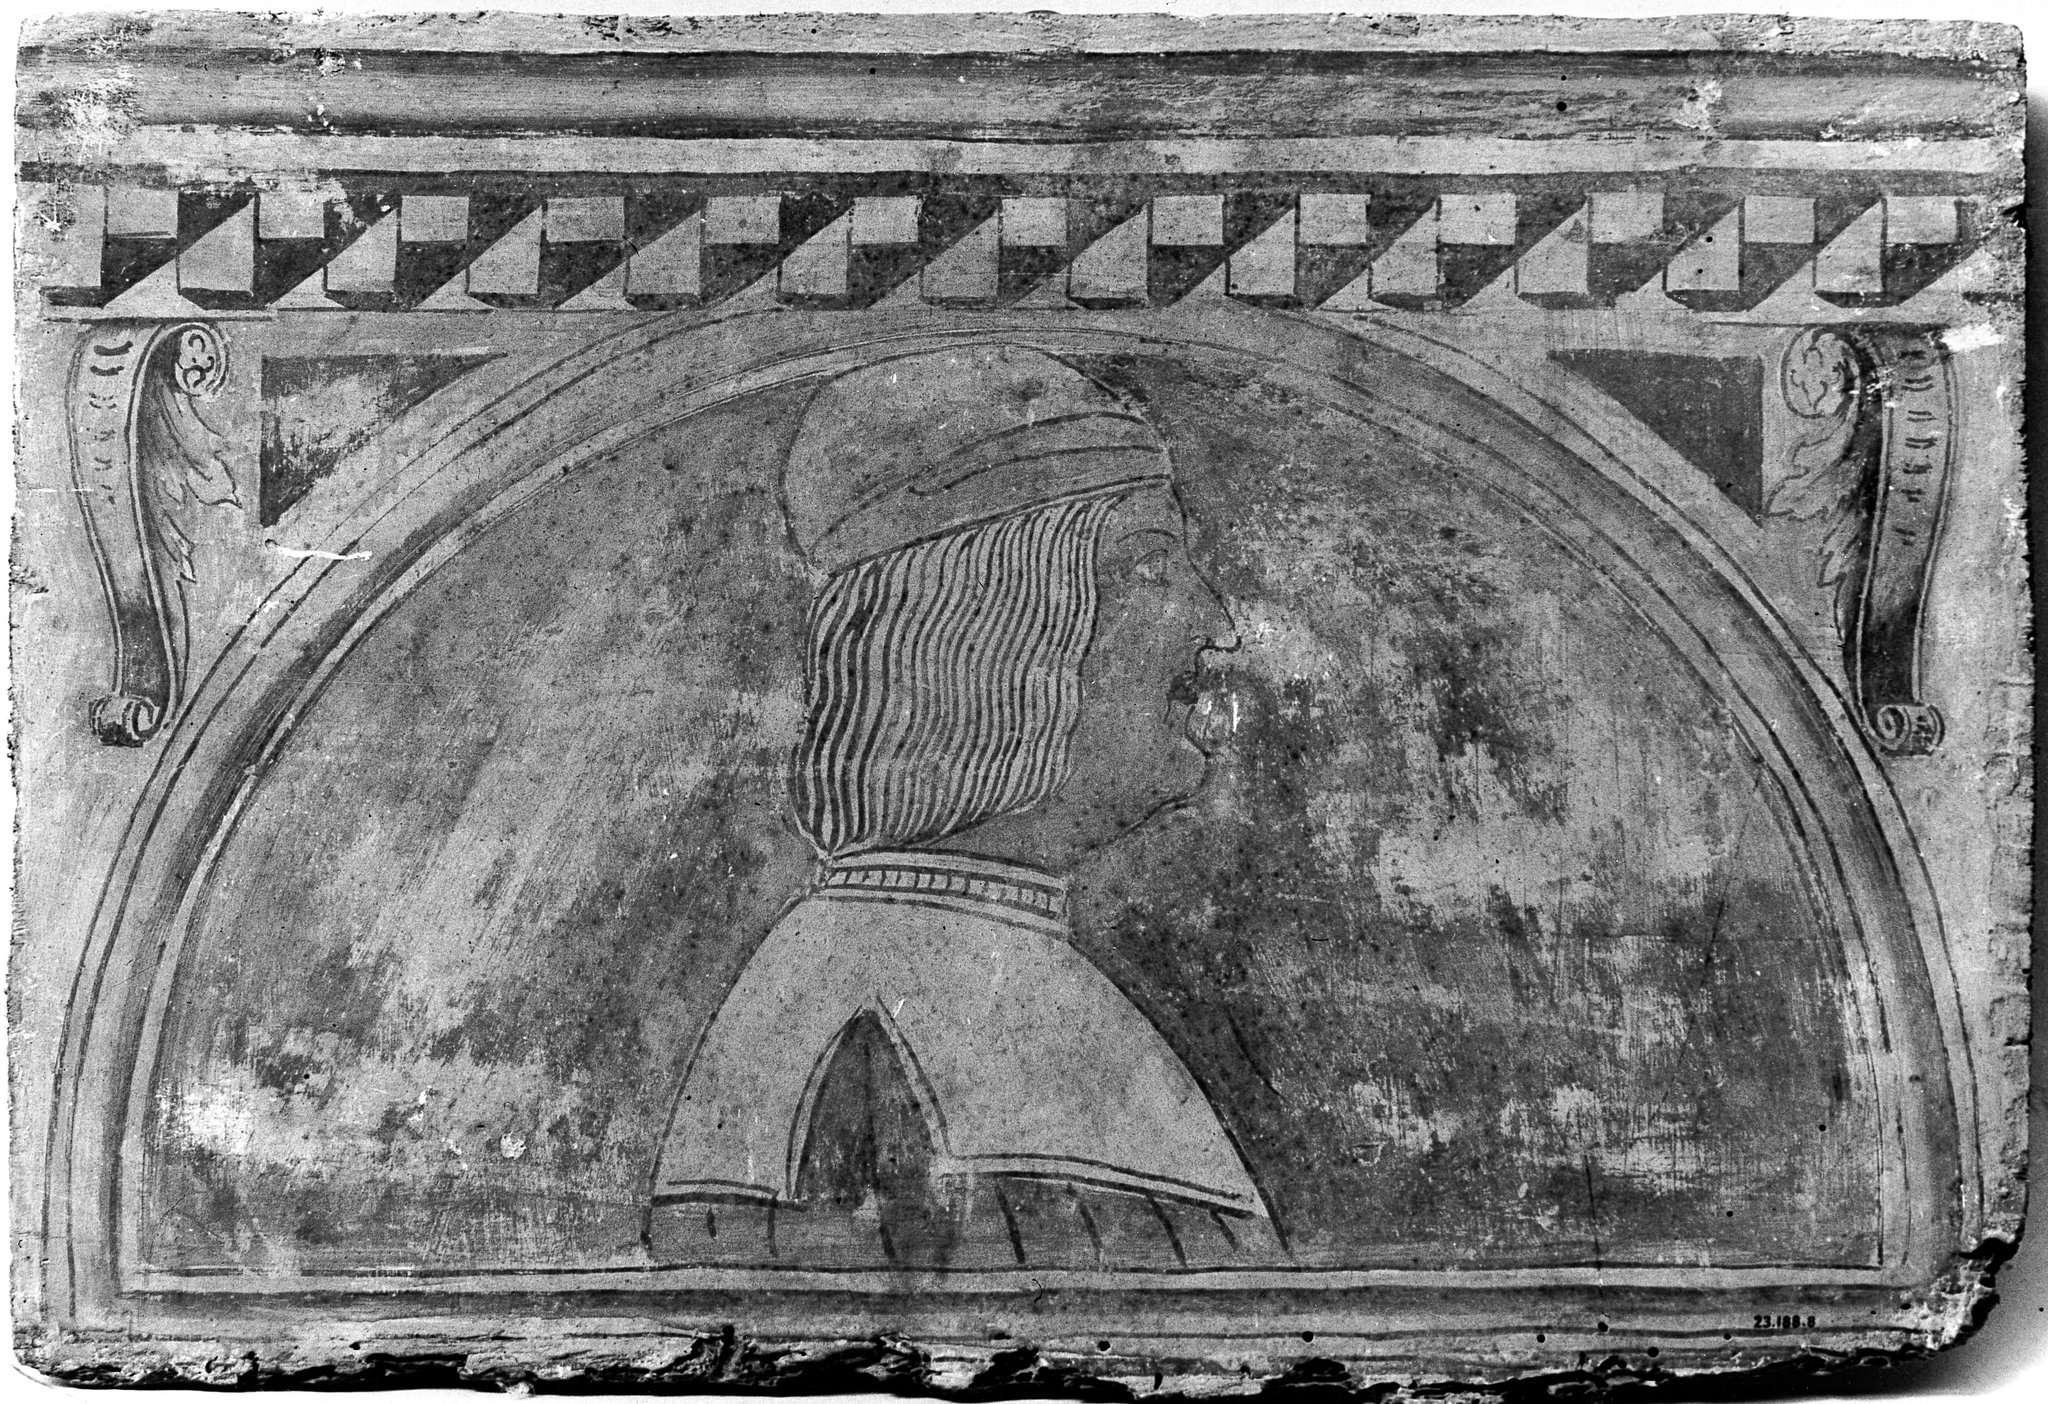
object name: frieze panel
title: Head of a man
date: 1501-1533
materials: paint, wood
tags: men,profiles